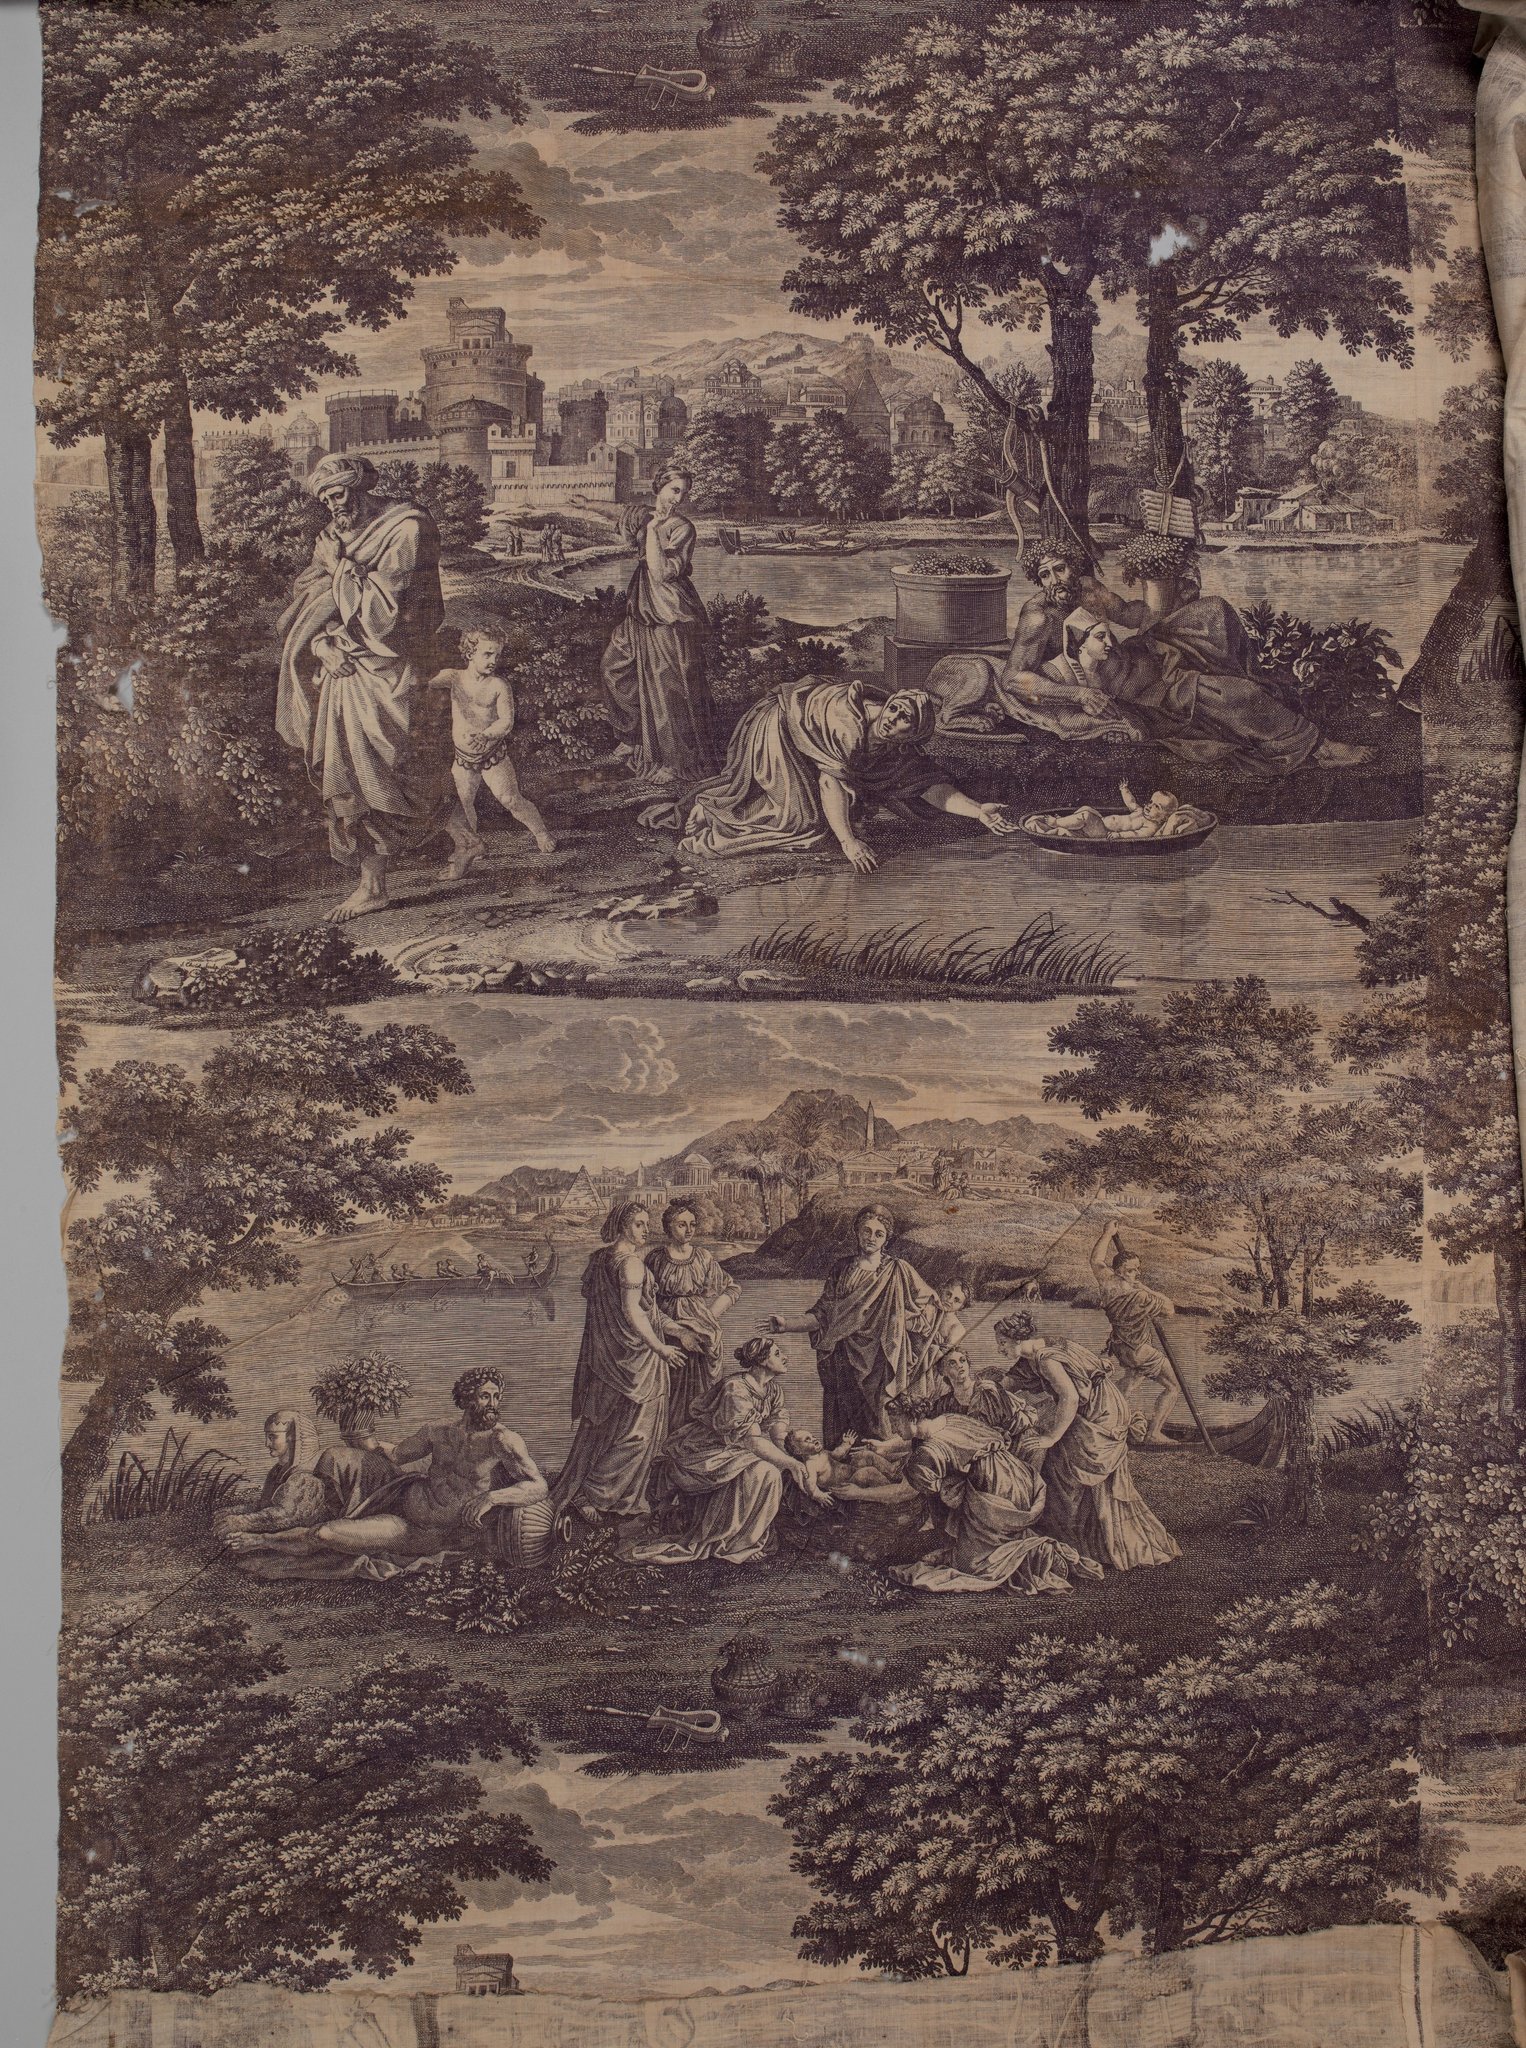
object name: length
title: Life of Moses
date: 1820-1829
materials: cotton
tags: children,men,women,landscapes,moses